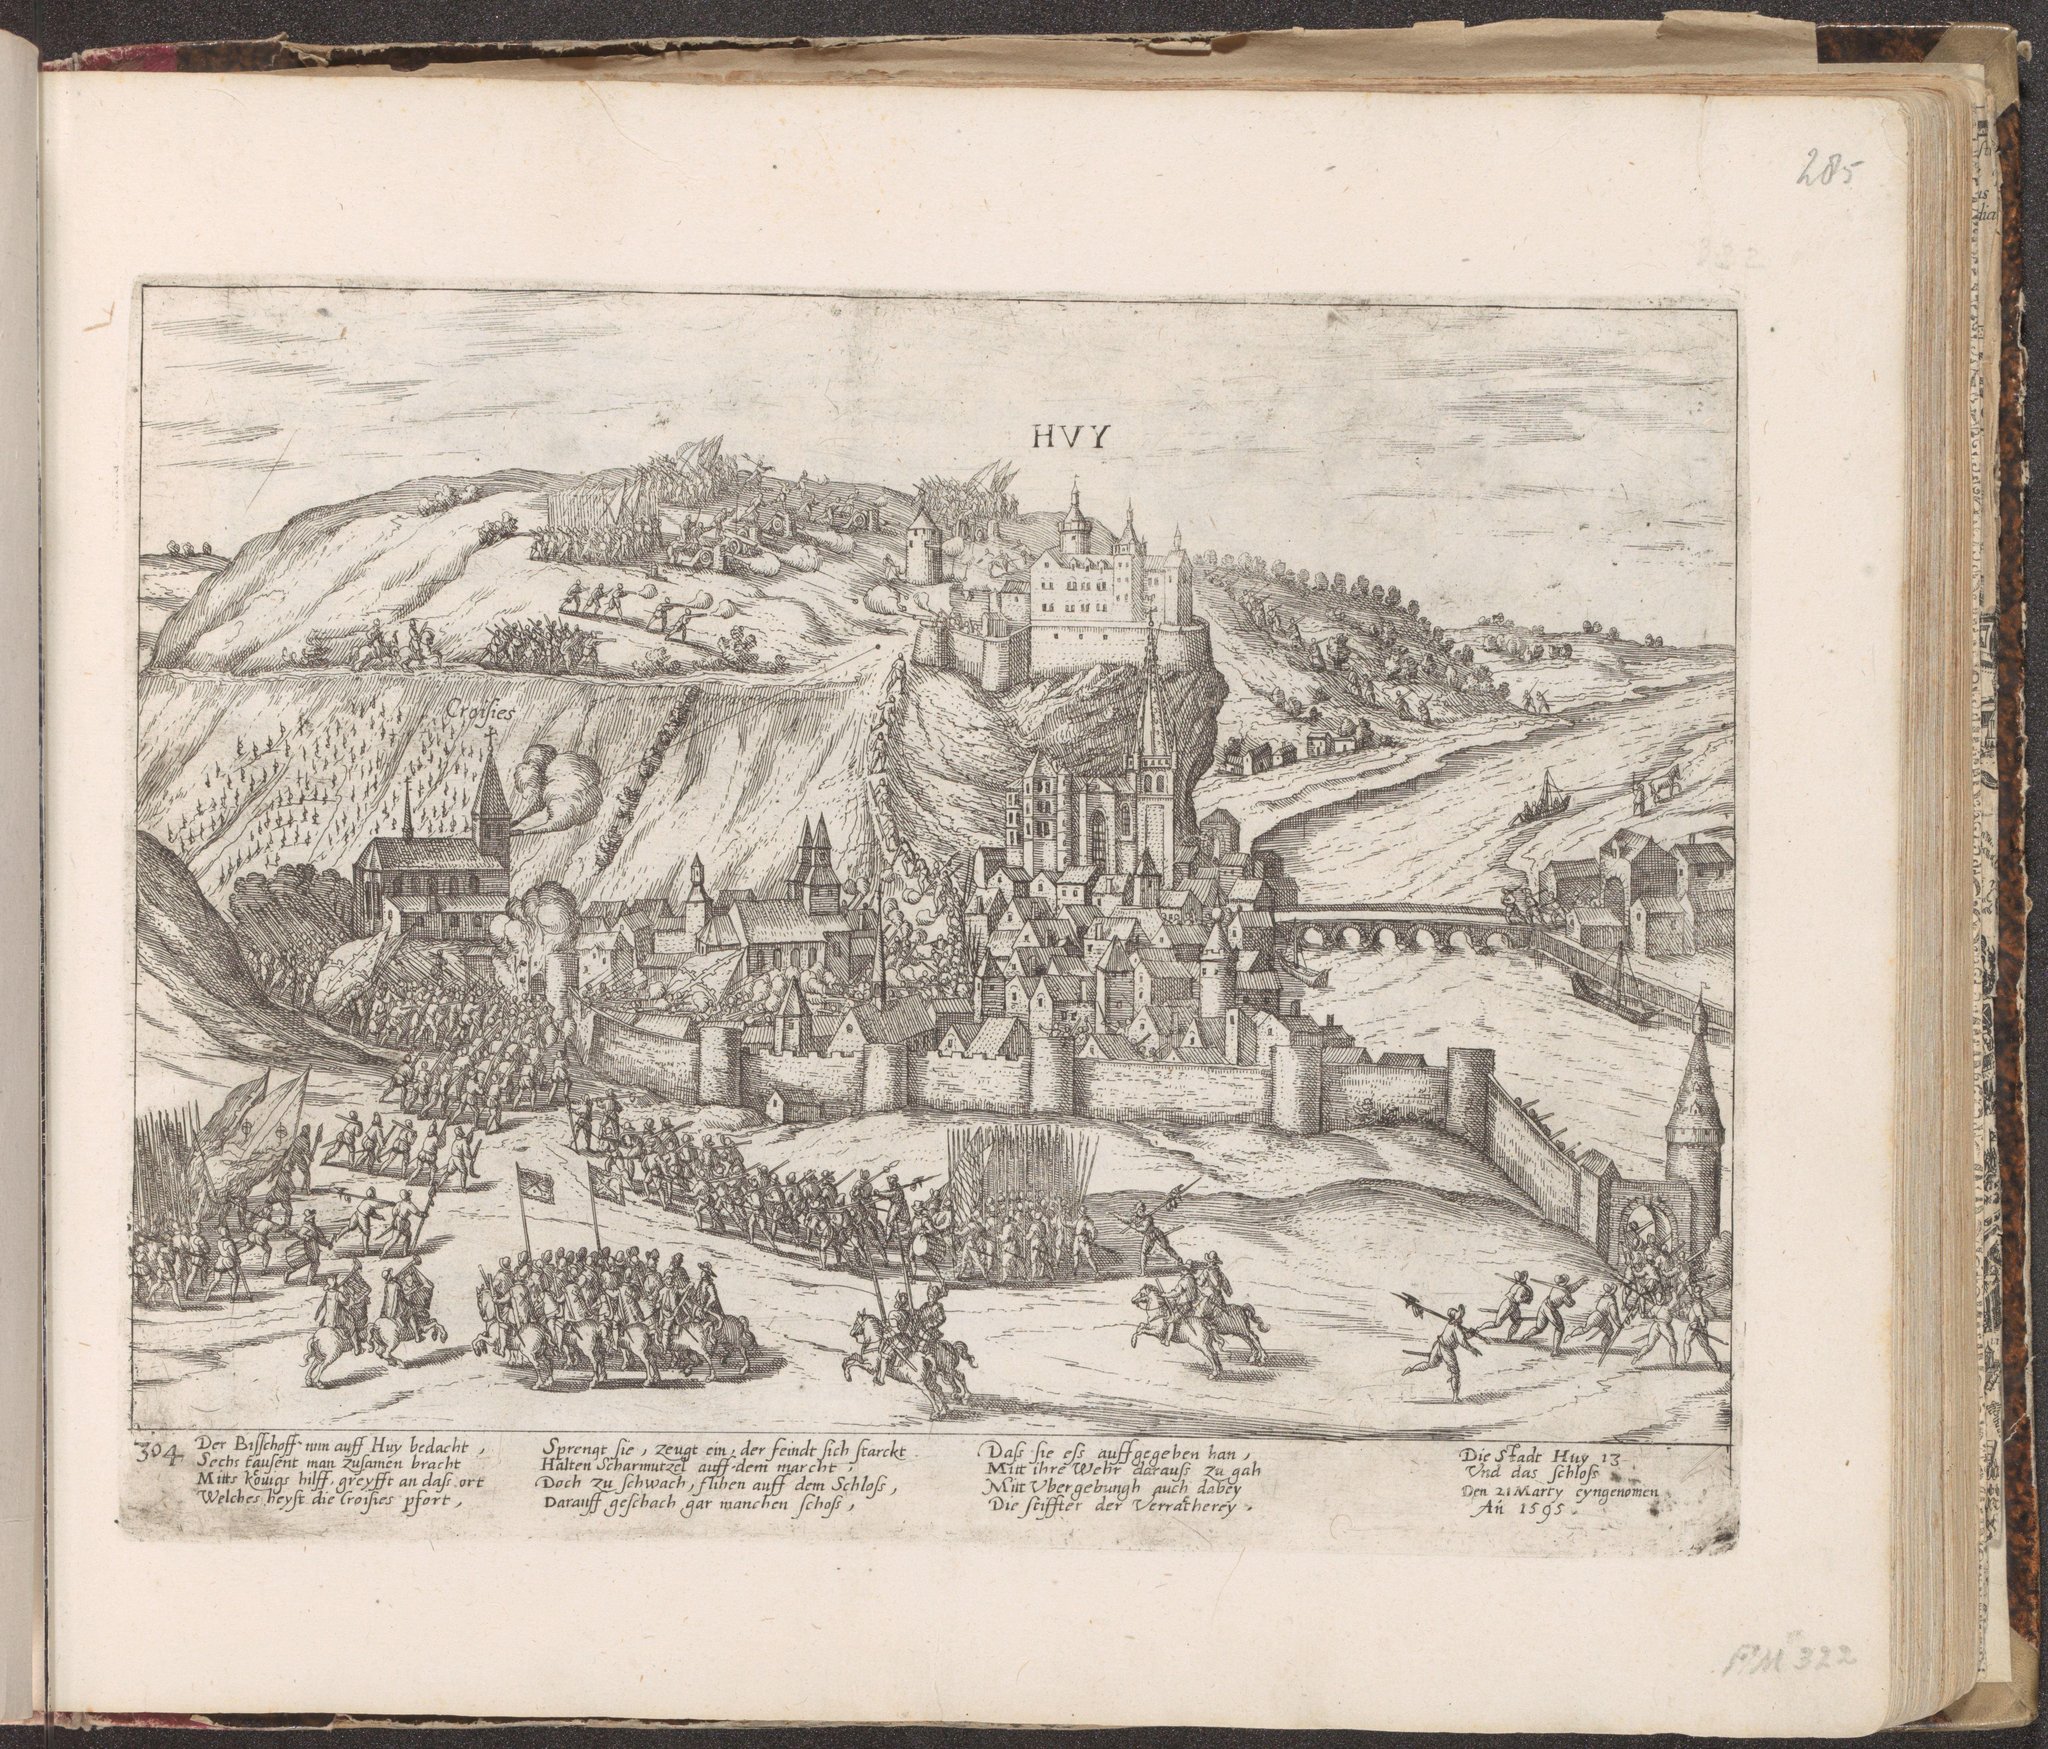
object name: album leaf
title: Serie 10: Nederlandse en Buitenlandse Gebeurtenissen, 1587-1612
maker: frans hogenberg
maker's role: print maker, publisher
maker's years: 1538-1590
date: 1595-1597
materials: paper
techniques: etching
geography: cologne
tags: capture of city (after the siege)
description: Herovering van Hoei door de bisschop van Luik op het Staatse leger, 21 maart 1595. Gezicht op de stad en het kasteel met gevechten tussen beide legers. Met onderschrift van 12 regels in het Duits. Linksonder genummerd: 304. De prent maakt deel uit van een album.